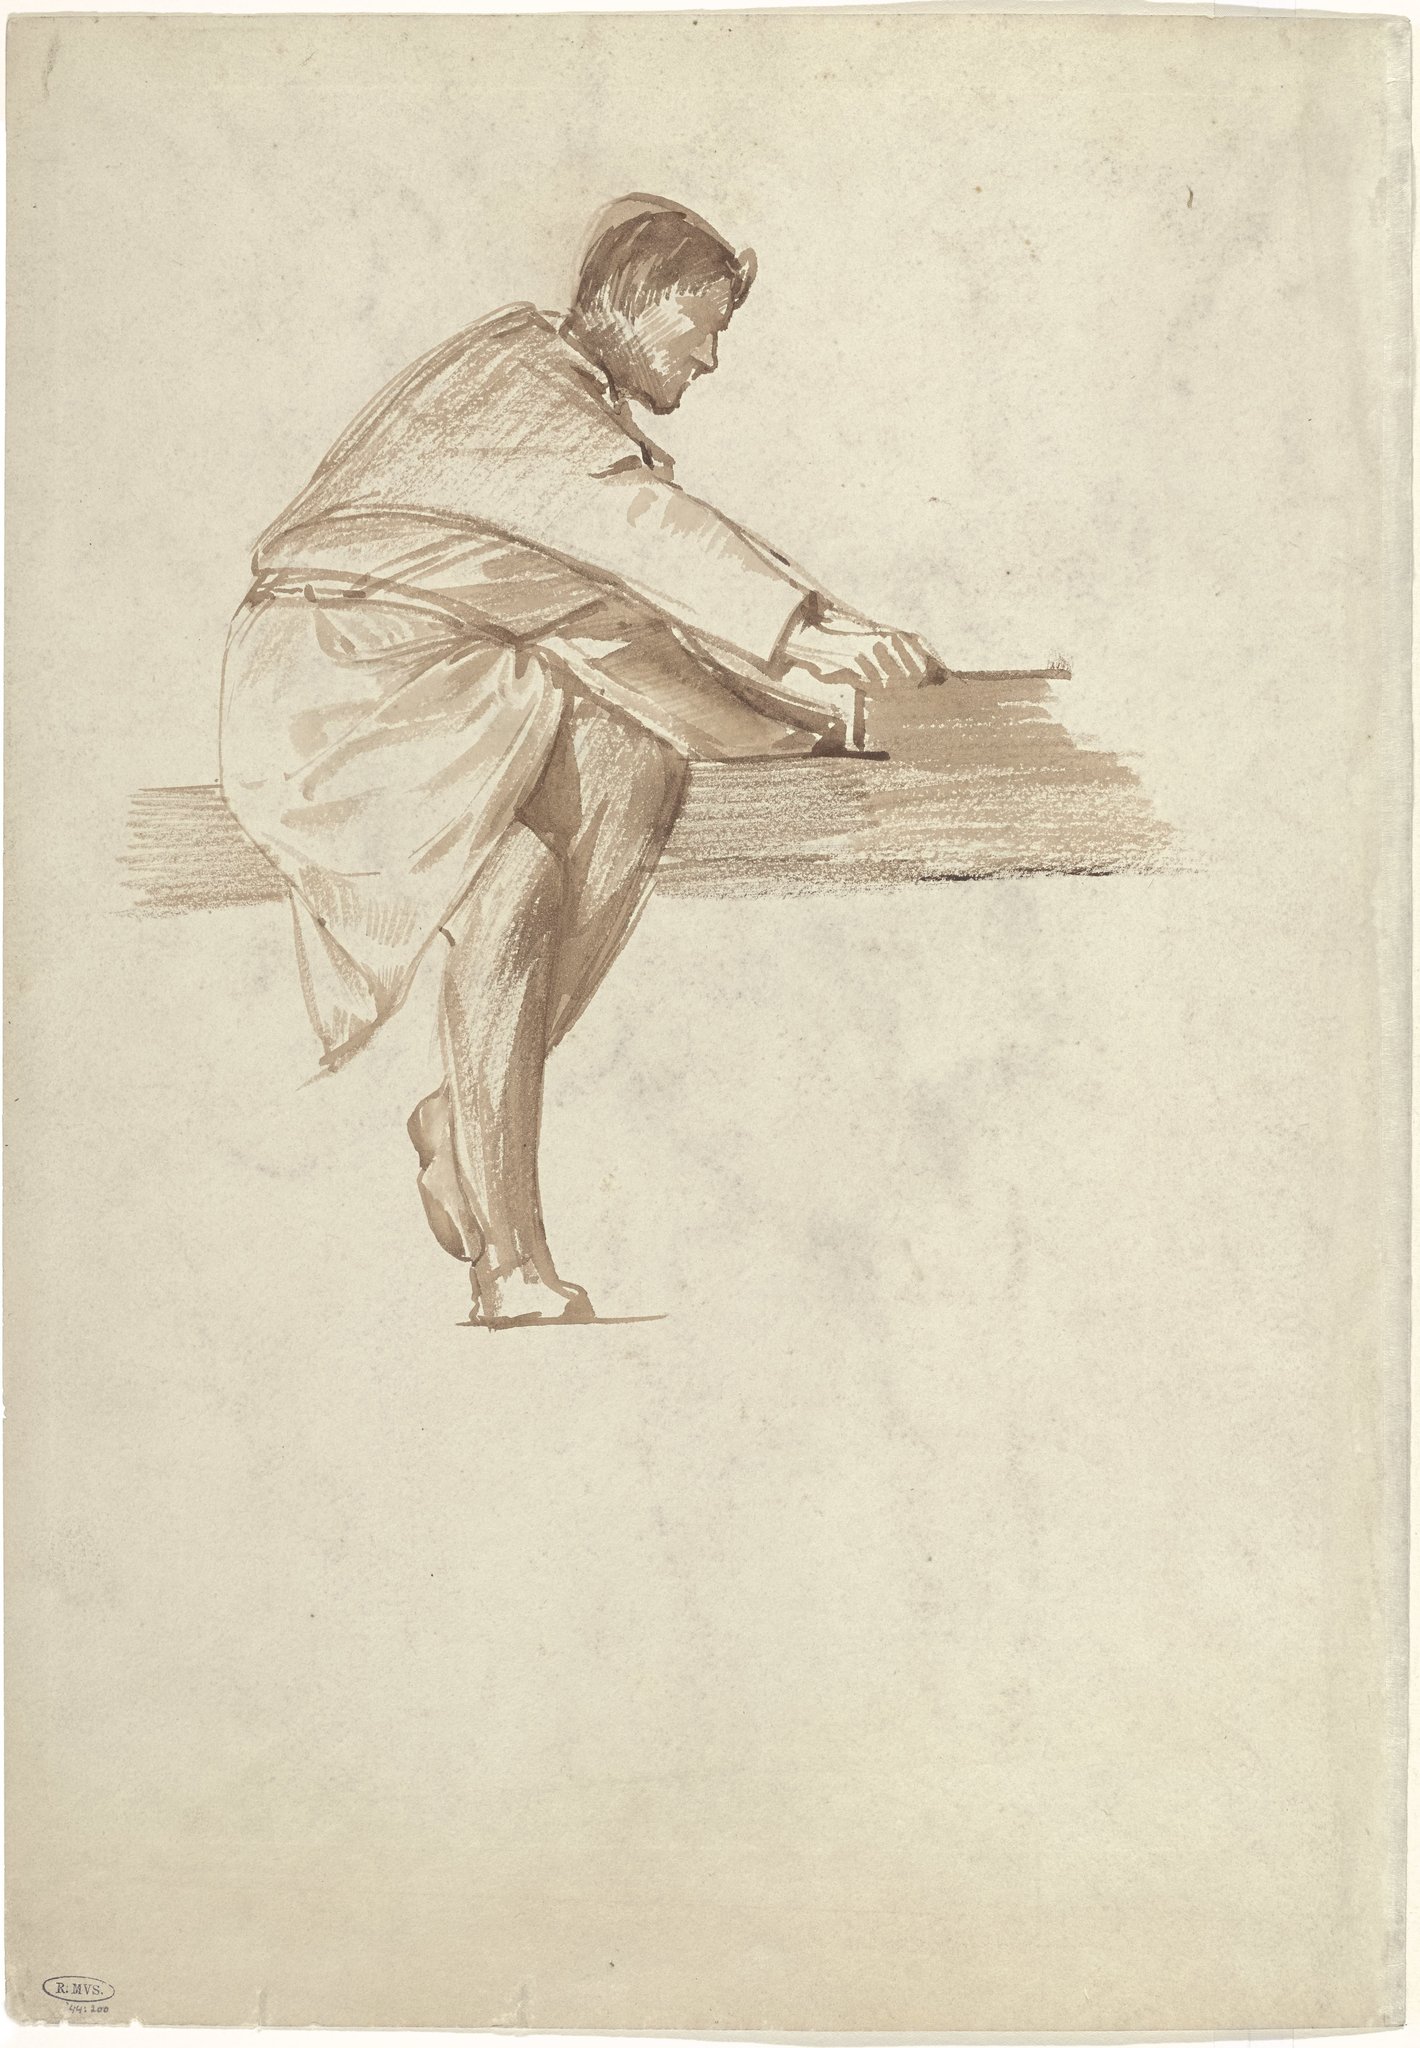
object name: drawing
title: Studie van een timmerman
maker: antoon derkinderen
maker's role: draughtsman, painter, print maker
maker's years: 1859-1925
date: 1869-1925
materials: paper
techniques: brush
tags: handicrafts ~ wood, timber